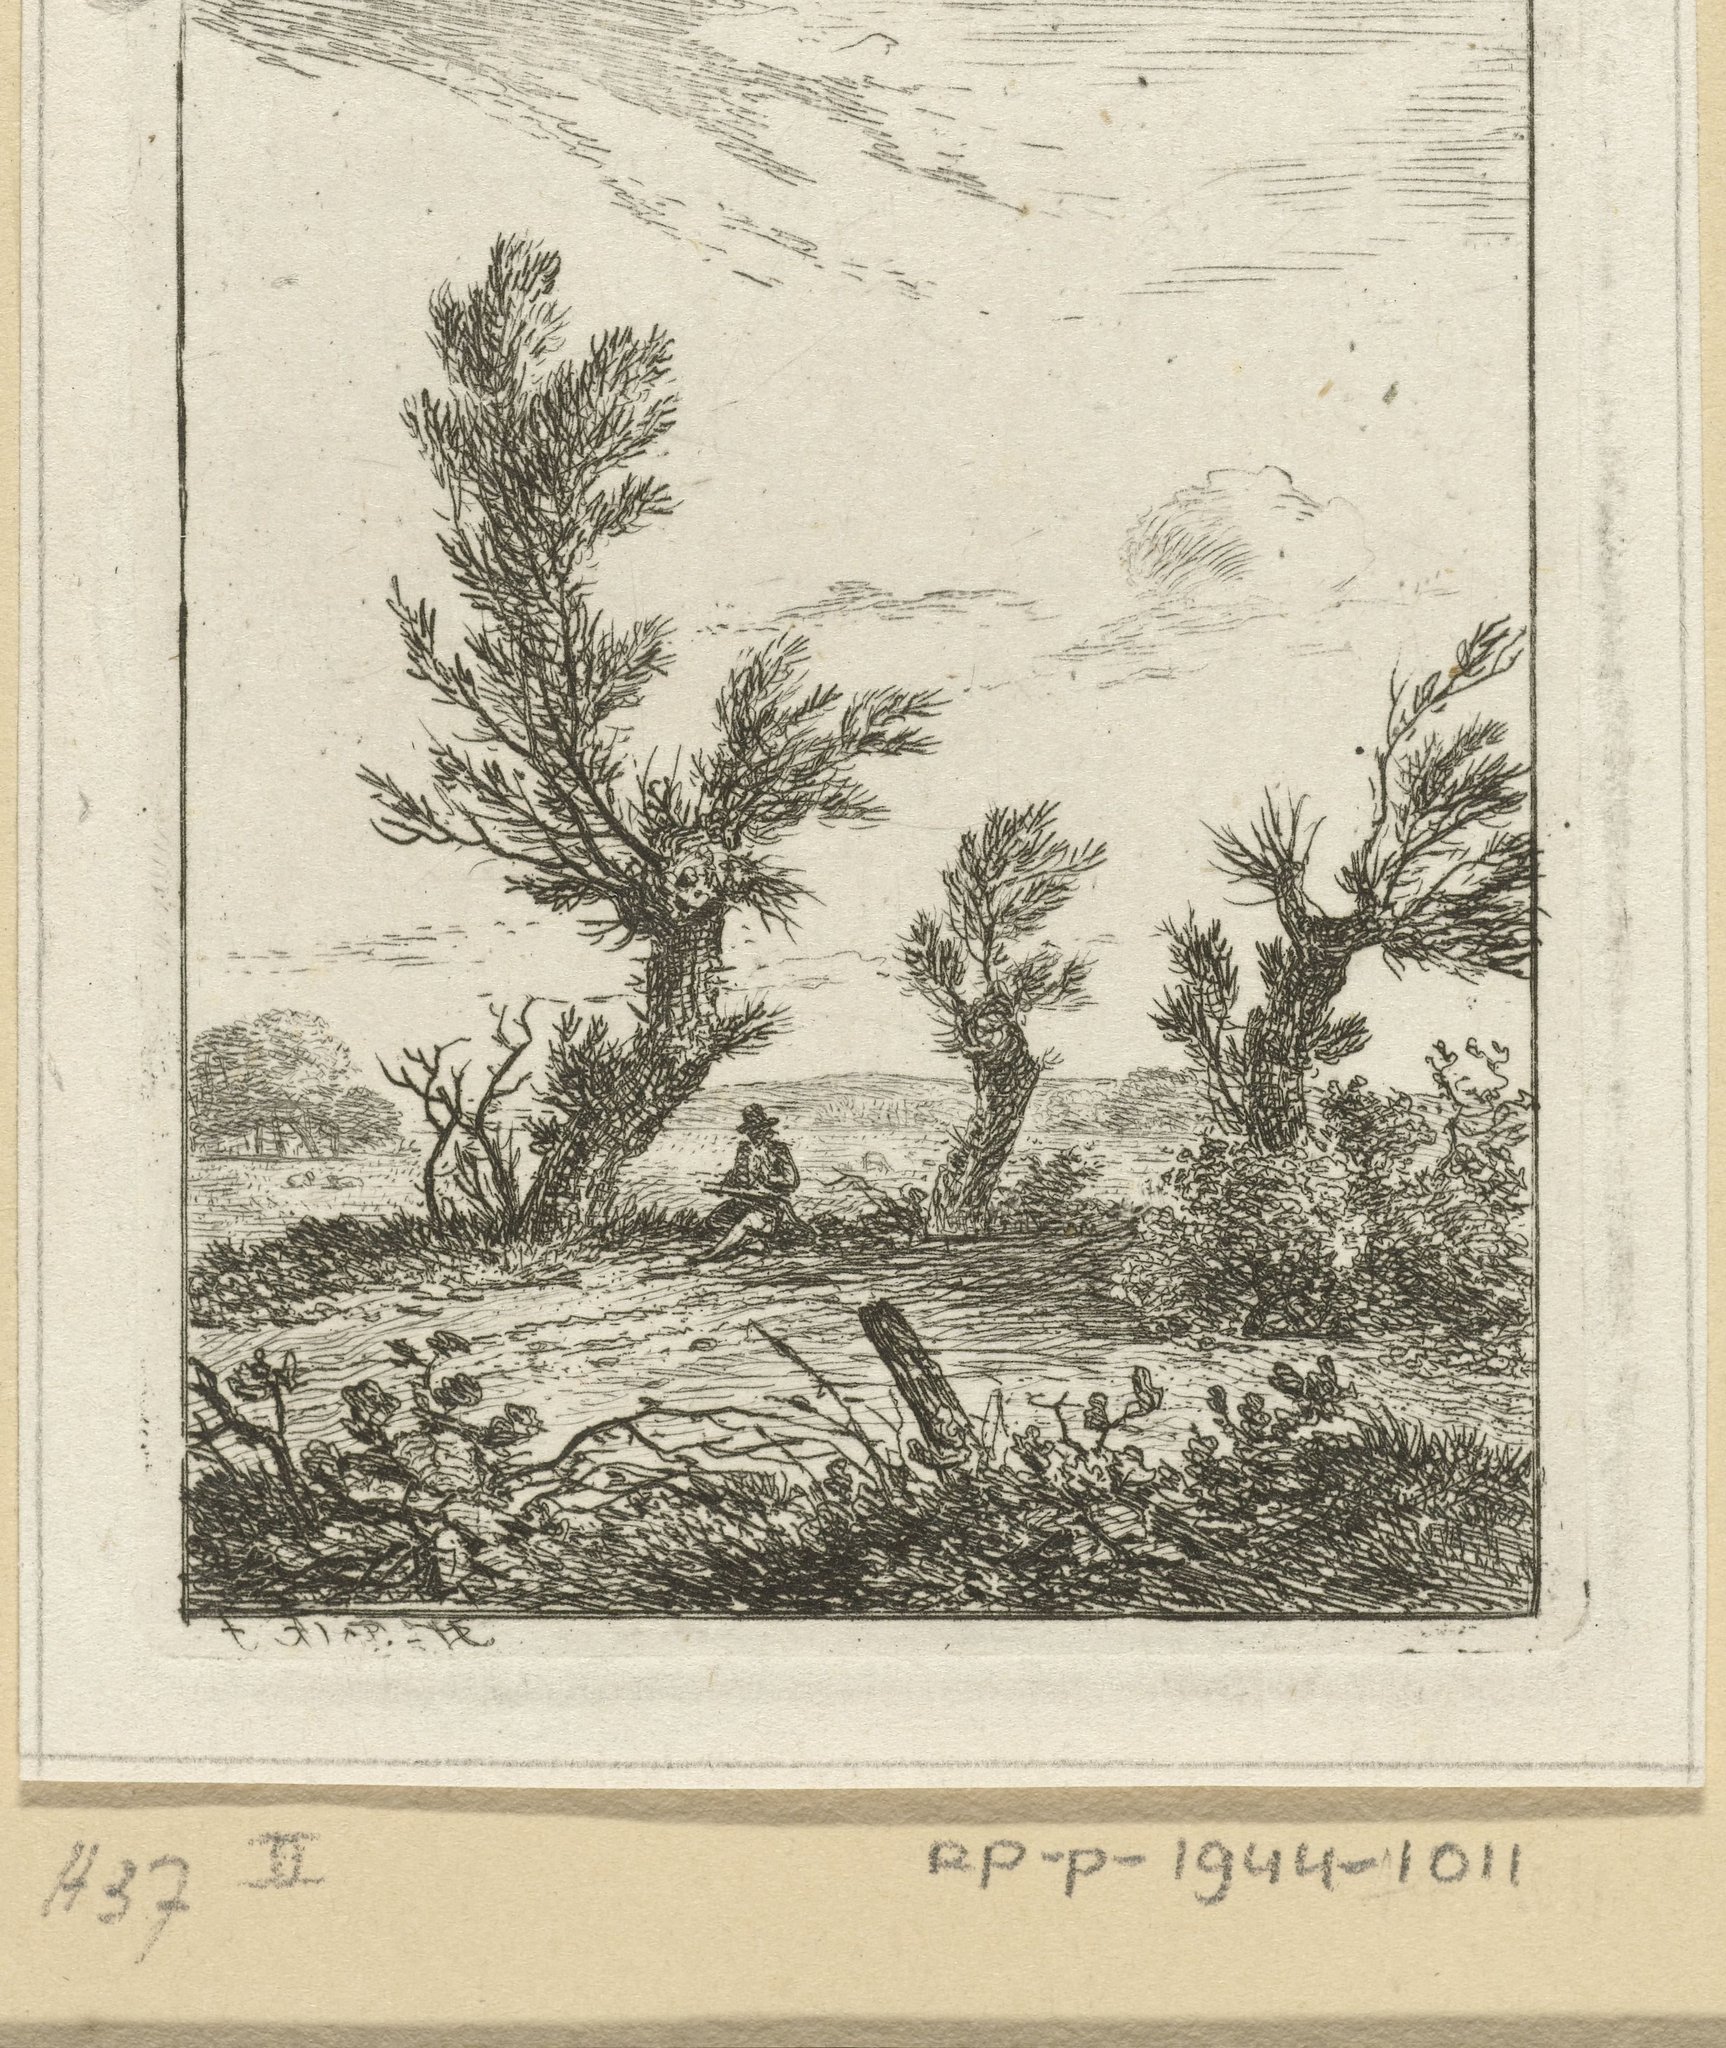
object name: print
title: Tekenaar tussen wilgen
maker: hermanus fock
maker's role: conservator, draughtsman, painter, print maker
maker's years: 1766-1822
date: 1781-1822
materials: paper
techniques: etching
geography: amsterdam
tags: artist at work, in his workshop - bb - out of doors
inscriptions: collector's mark: Lugt 924, collector's mark: Lugt 2228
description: Een landschap met drie wilgen naast elkaar. Tussen de bomen zit een man met een schetsboek.